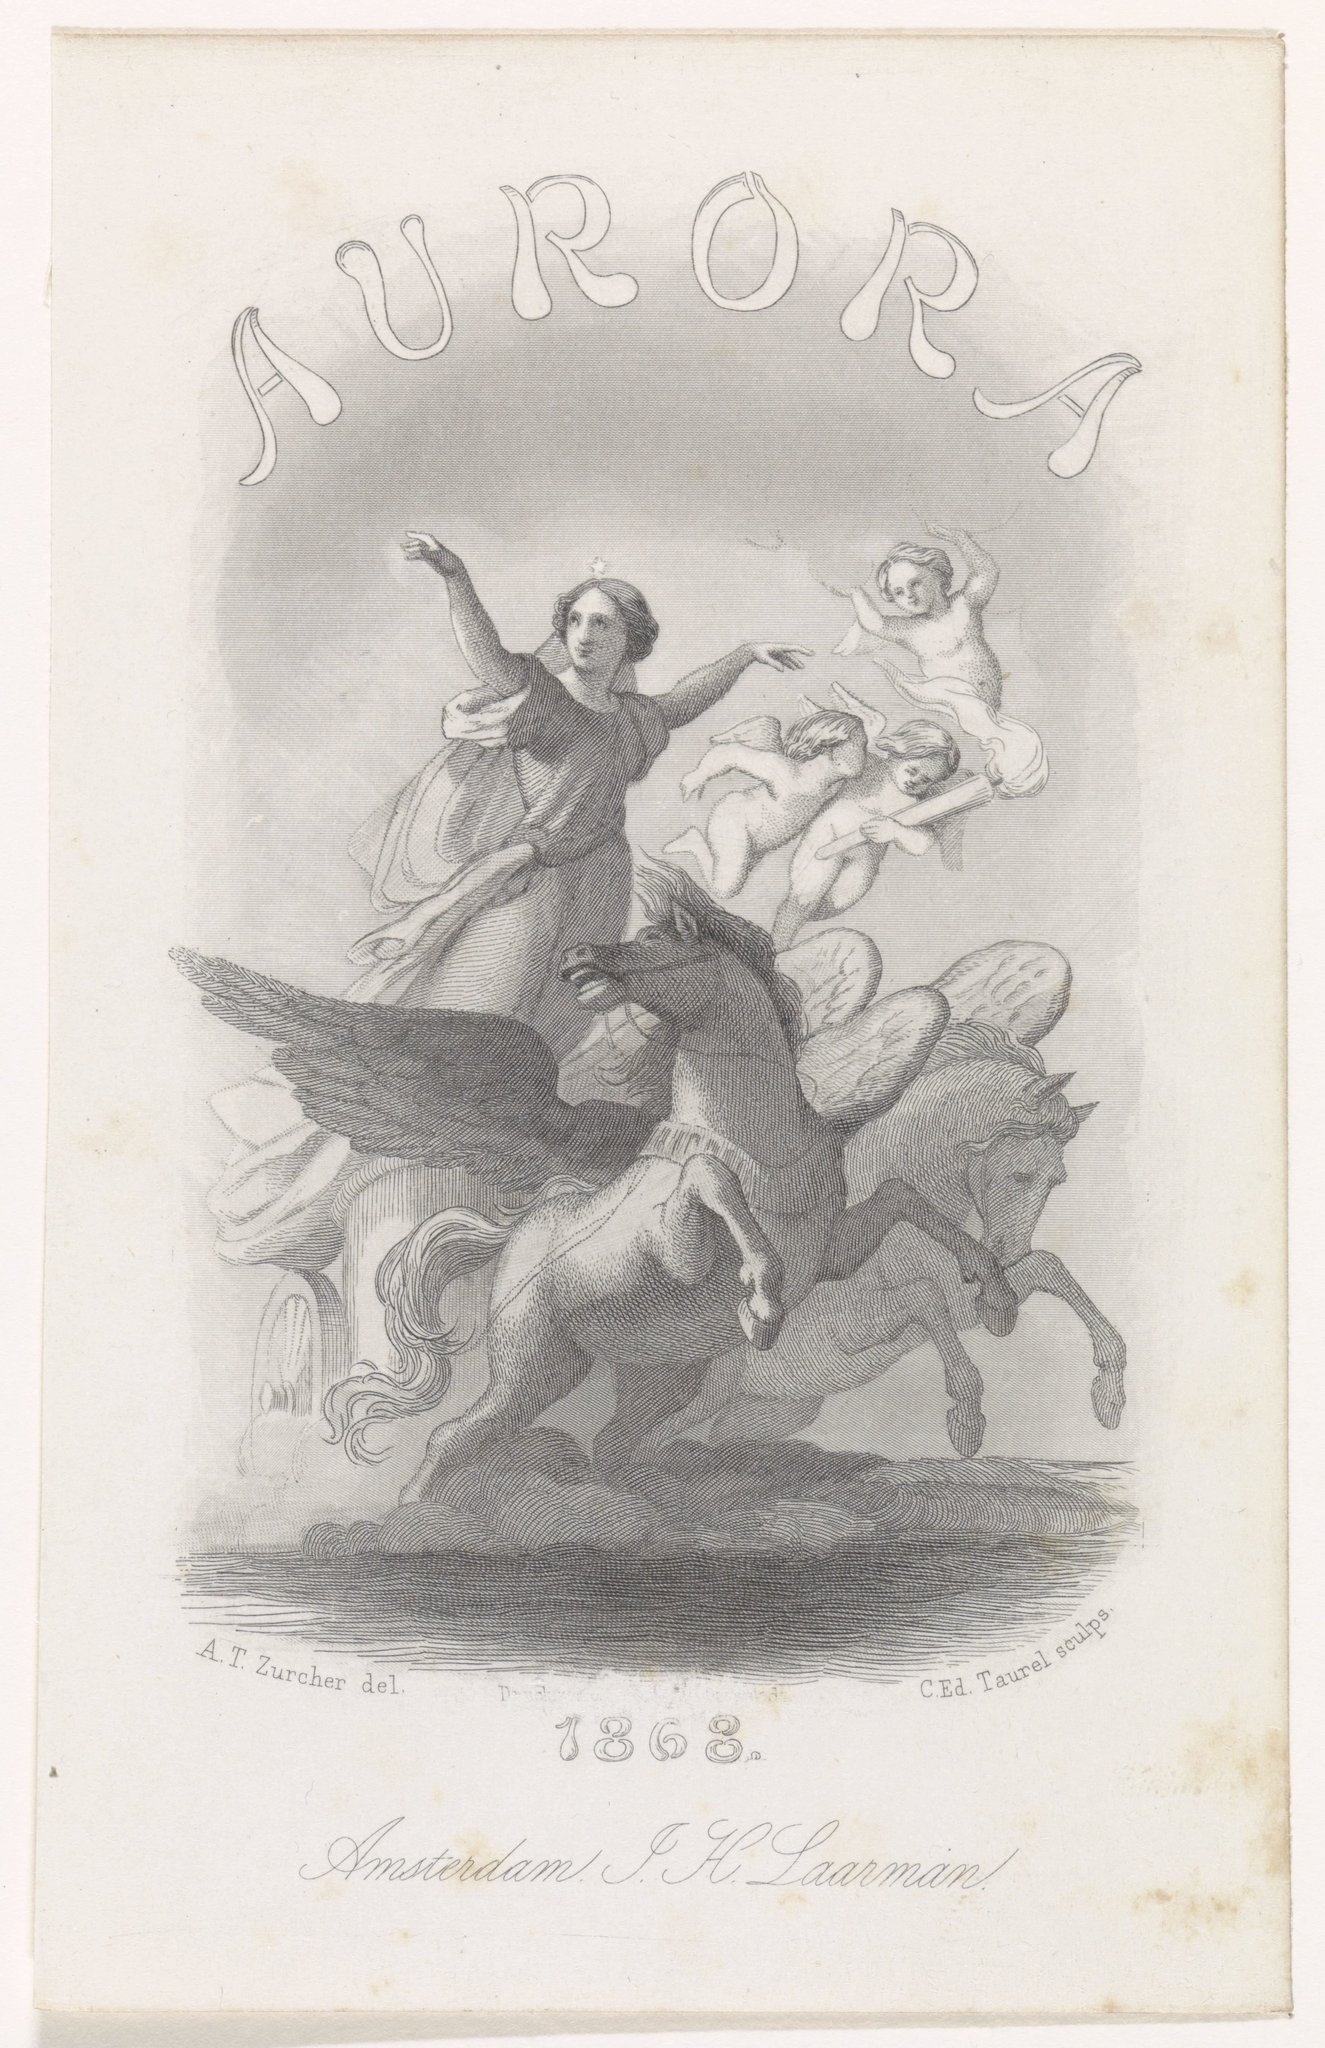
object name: titelblad, titelpagina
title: Aurora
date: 1868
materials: paper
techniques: engraving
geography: amsterdam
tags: personification of the morning, 'aurora'; 'aurora' (ripa), (story of) aurora (eos); 'aurora' (ripa)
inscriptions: collector's mark: Lugt 2228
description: De godin van het ochtendgloren, Aurora, staand op een door twee gevleugelde paarden getrokken wagen. In de lucht drie putti waarvan één een brandende fakkel vasthoudt.